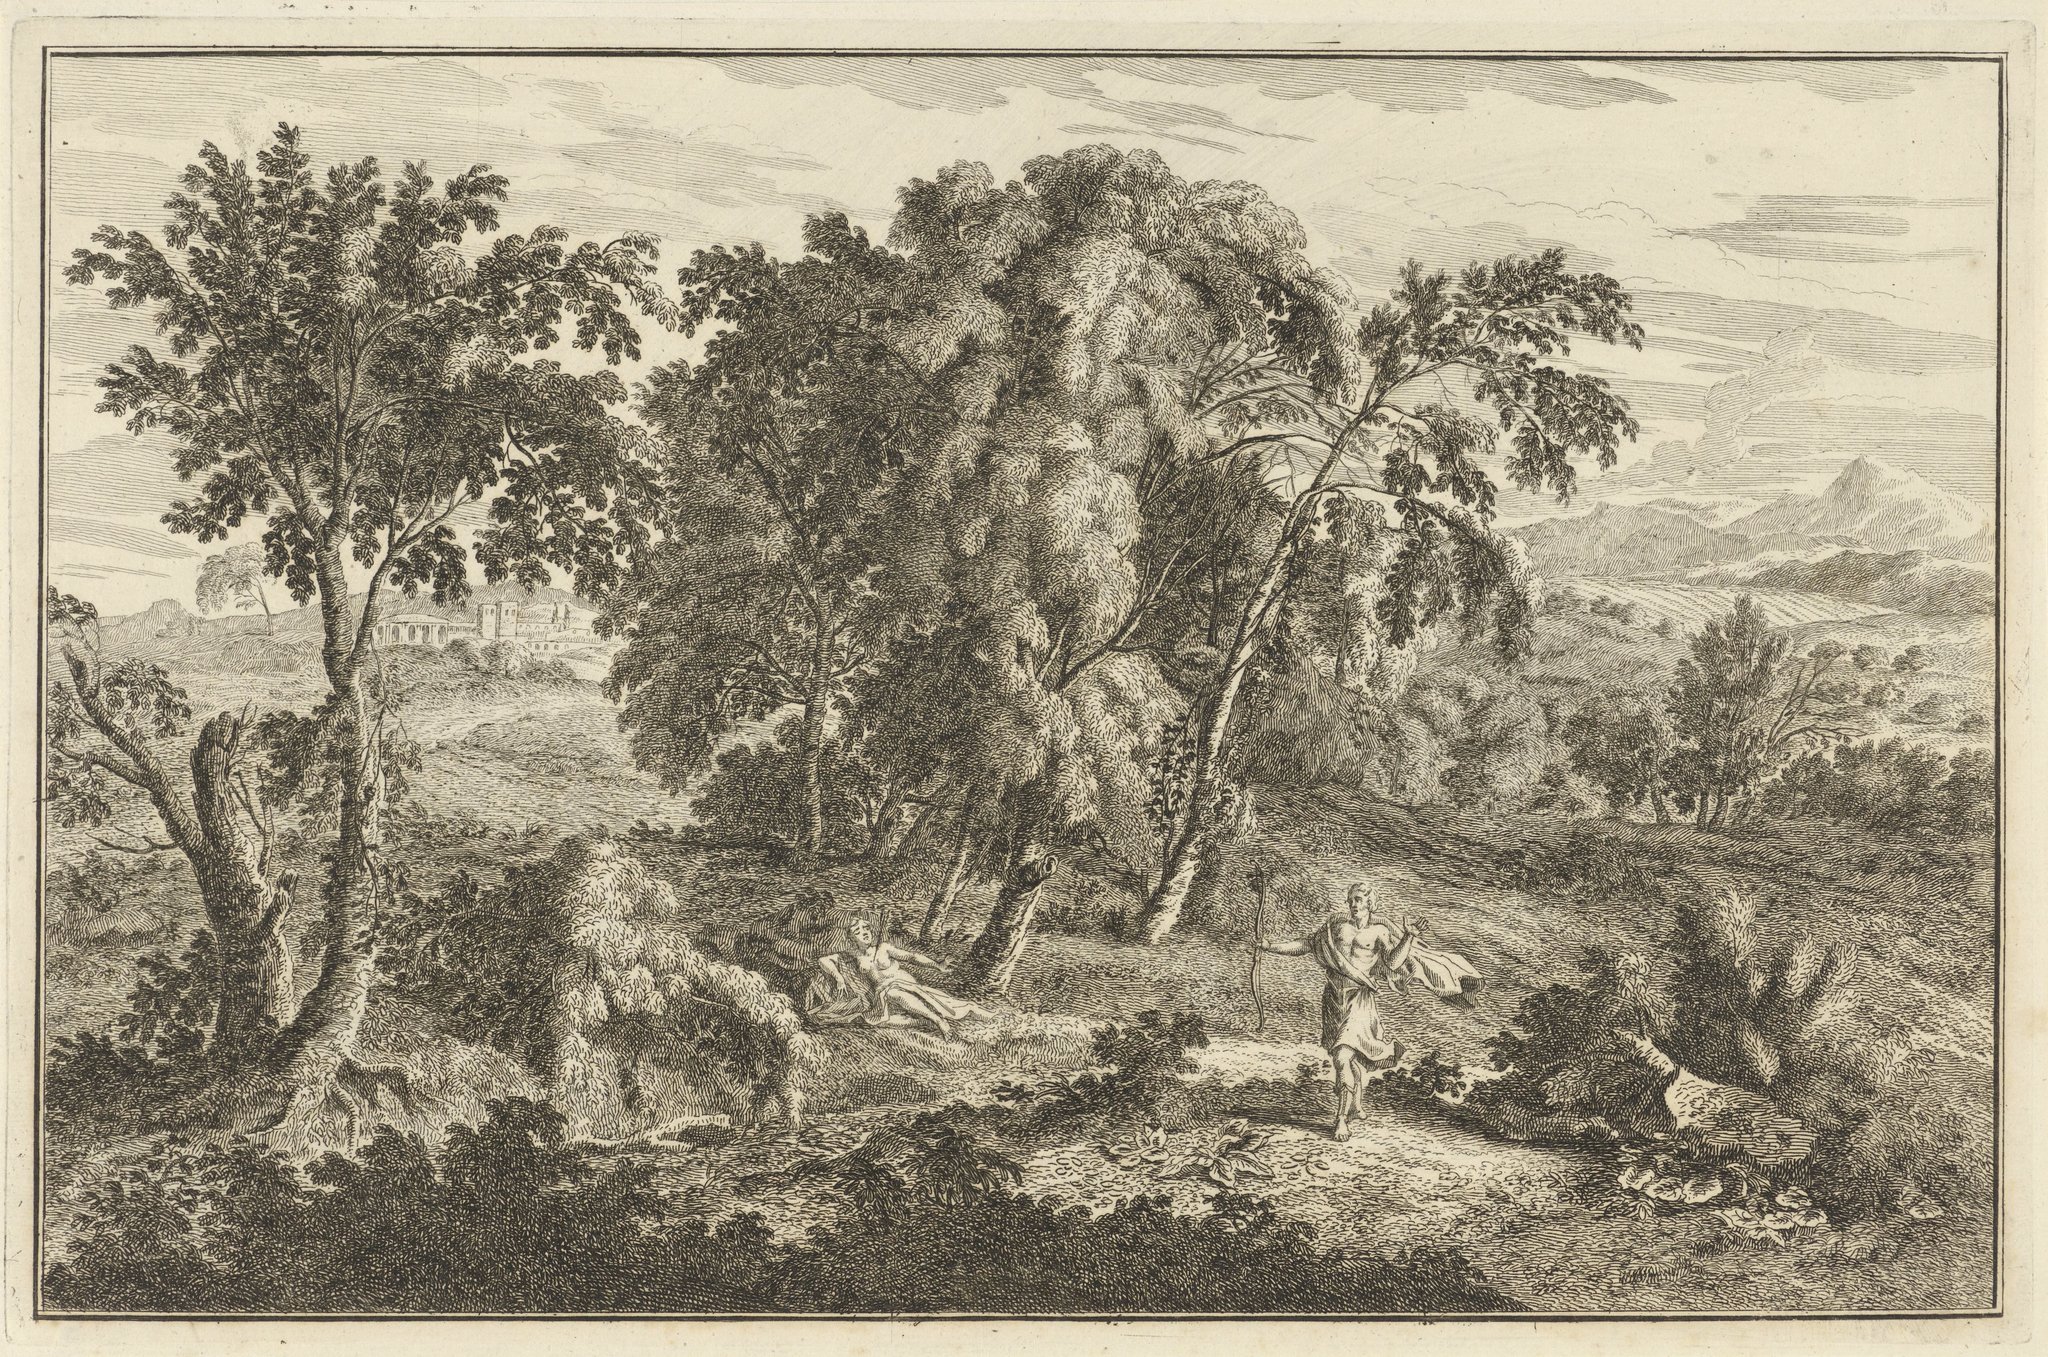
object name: print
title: Italiaanse en Duitse landschappen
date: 1710-1747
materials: paper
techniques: etching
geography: amsterdam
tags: shooting with bow and arrow, archery (~ games of skill) (+ variant), landscapes with waters, waterscapes, seascapes (in the temperate zone)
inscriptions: collector's mark: Lugt 240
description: Arcadisch landschap met links een naakte vrouw met een pijl in haar borst. De pijl is afgeschoten door de man voor haar. De prent maakt deel uit van een 40-delige serie prenten met voorstellingen van Italiaanse en Duitse landschappen.